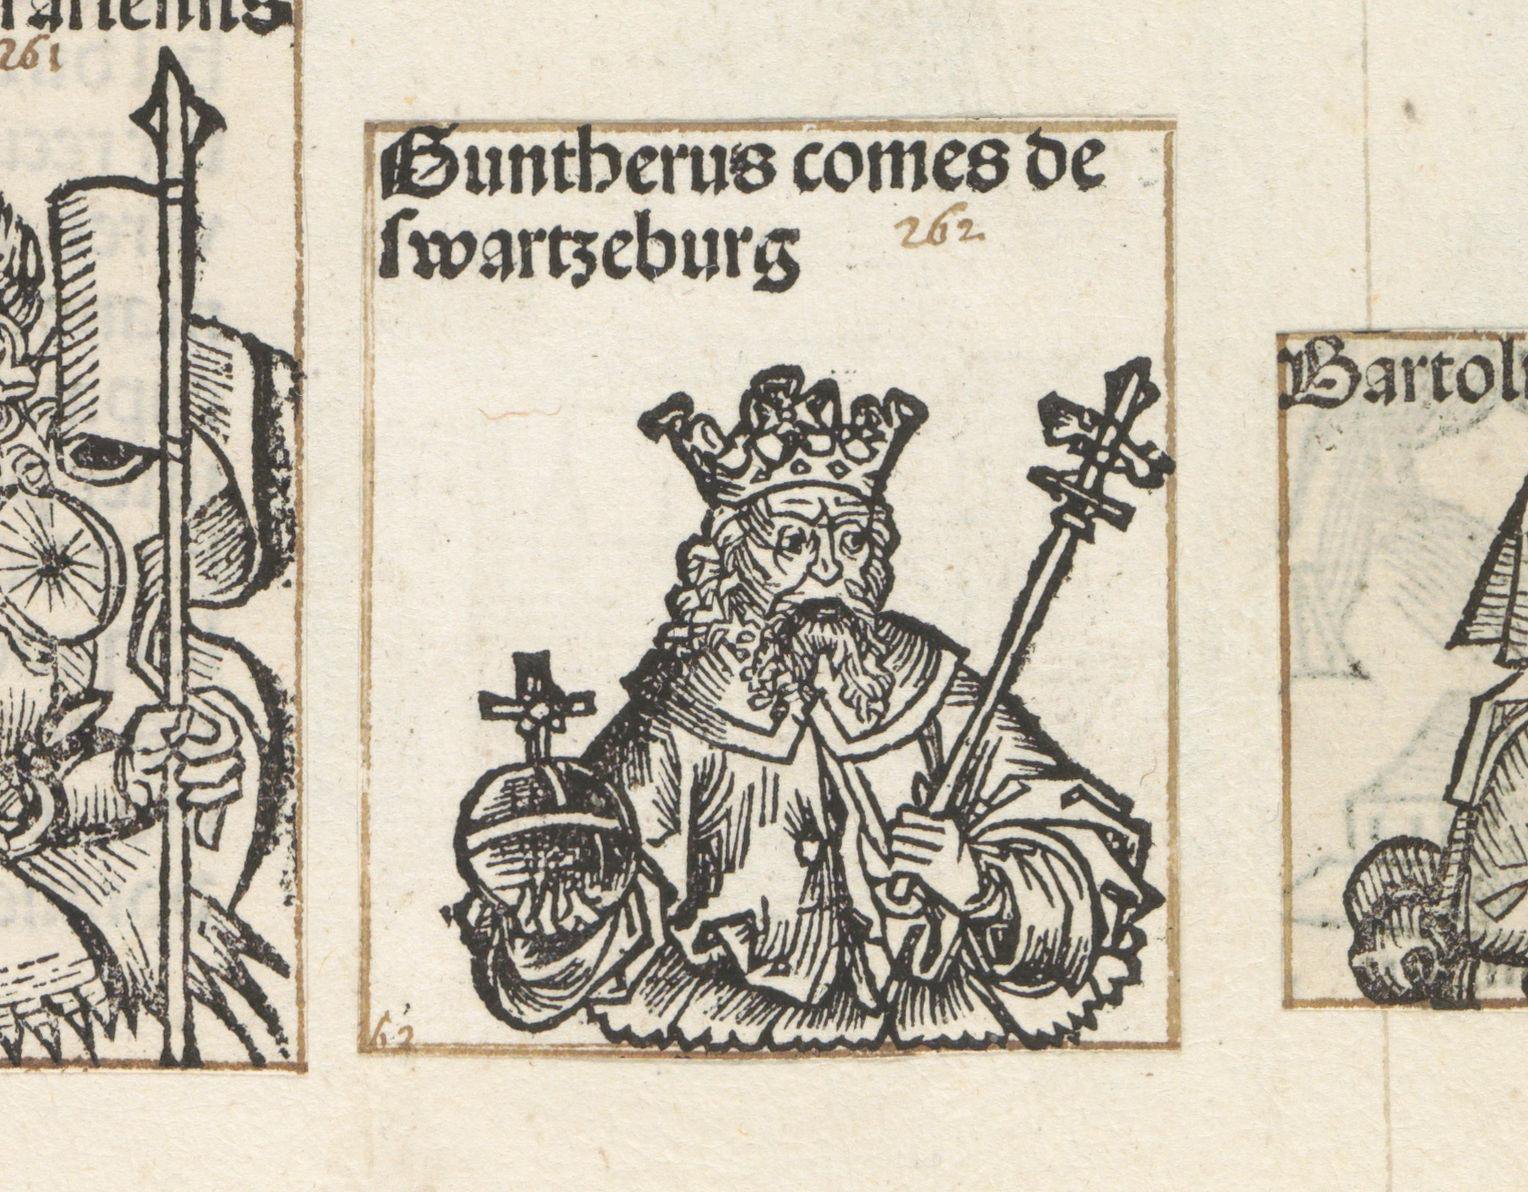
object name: book illustration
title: Günther XXI van Schwarzburg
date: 1493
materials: paper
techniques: letterpress printing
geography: nuremberg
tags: king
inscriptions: inscription: ‘262’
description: De houtsnede wordt herhaaldelijk gebruikt als boekillustratie in de Liber Chronicarum (of Neurenbergkroniek) van Hartmann Schedel, verschenen in het Latijn en Duits in 1493. Zie de Latijnse uitgave, folio 229r.